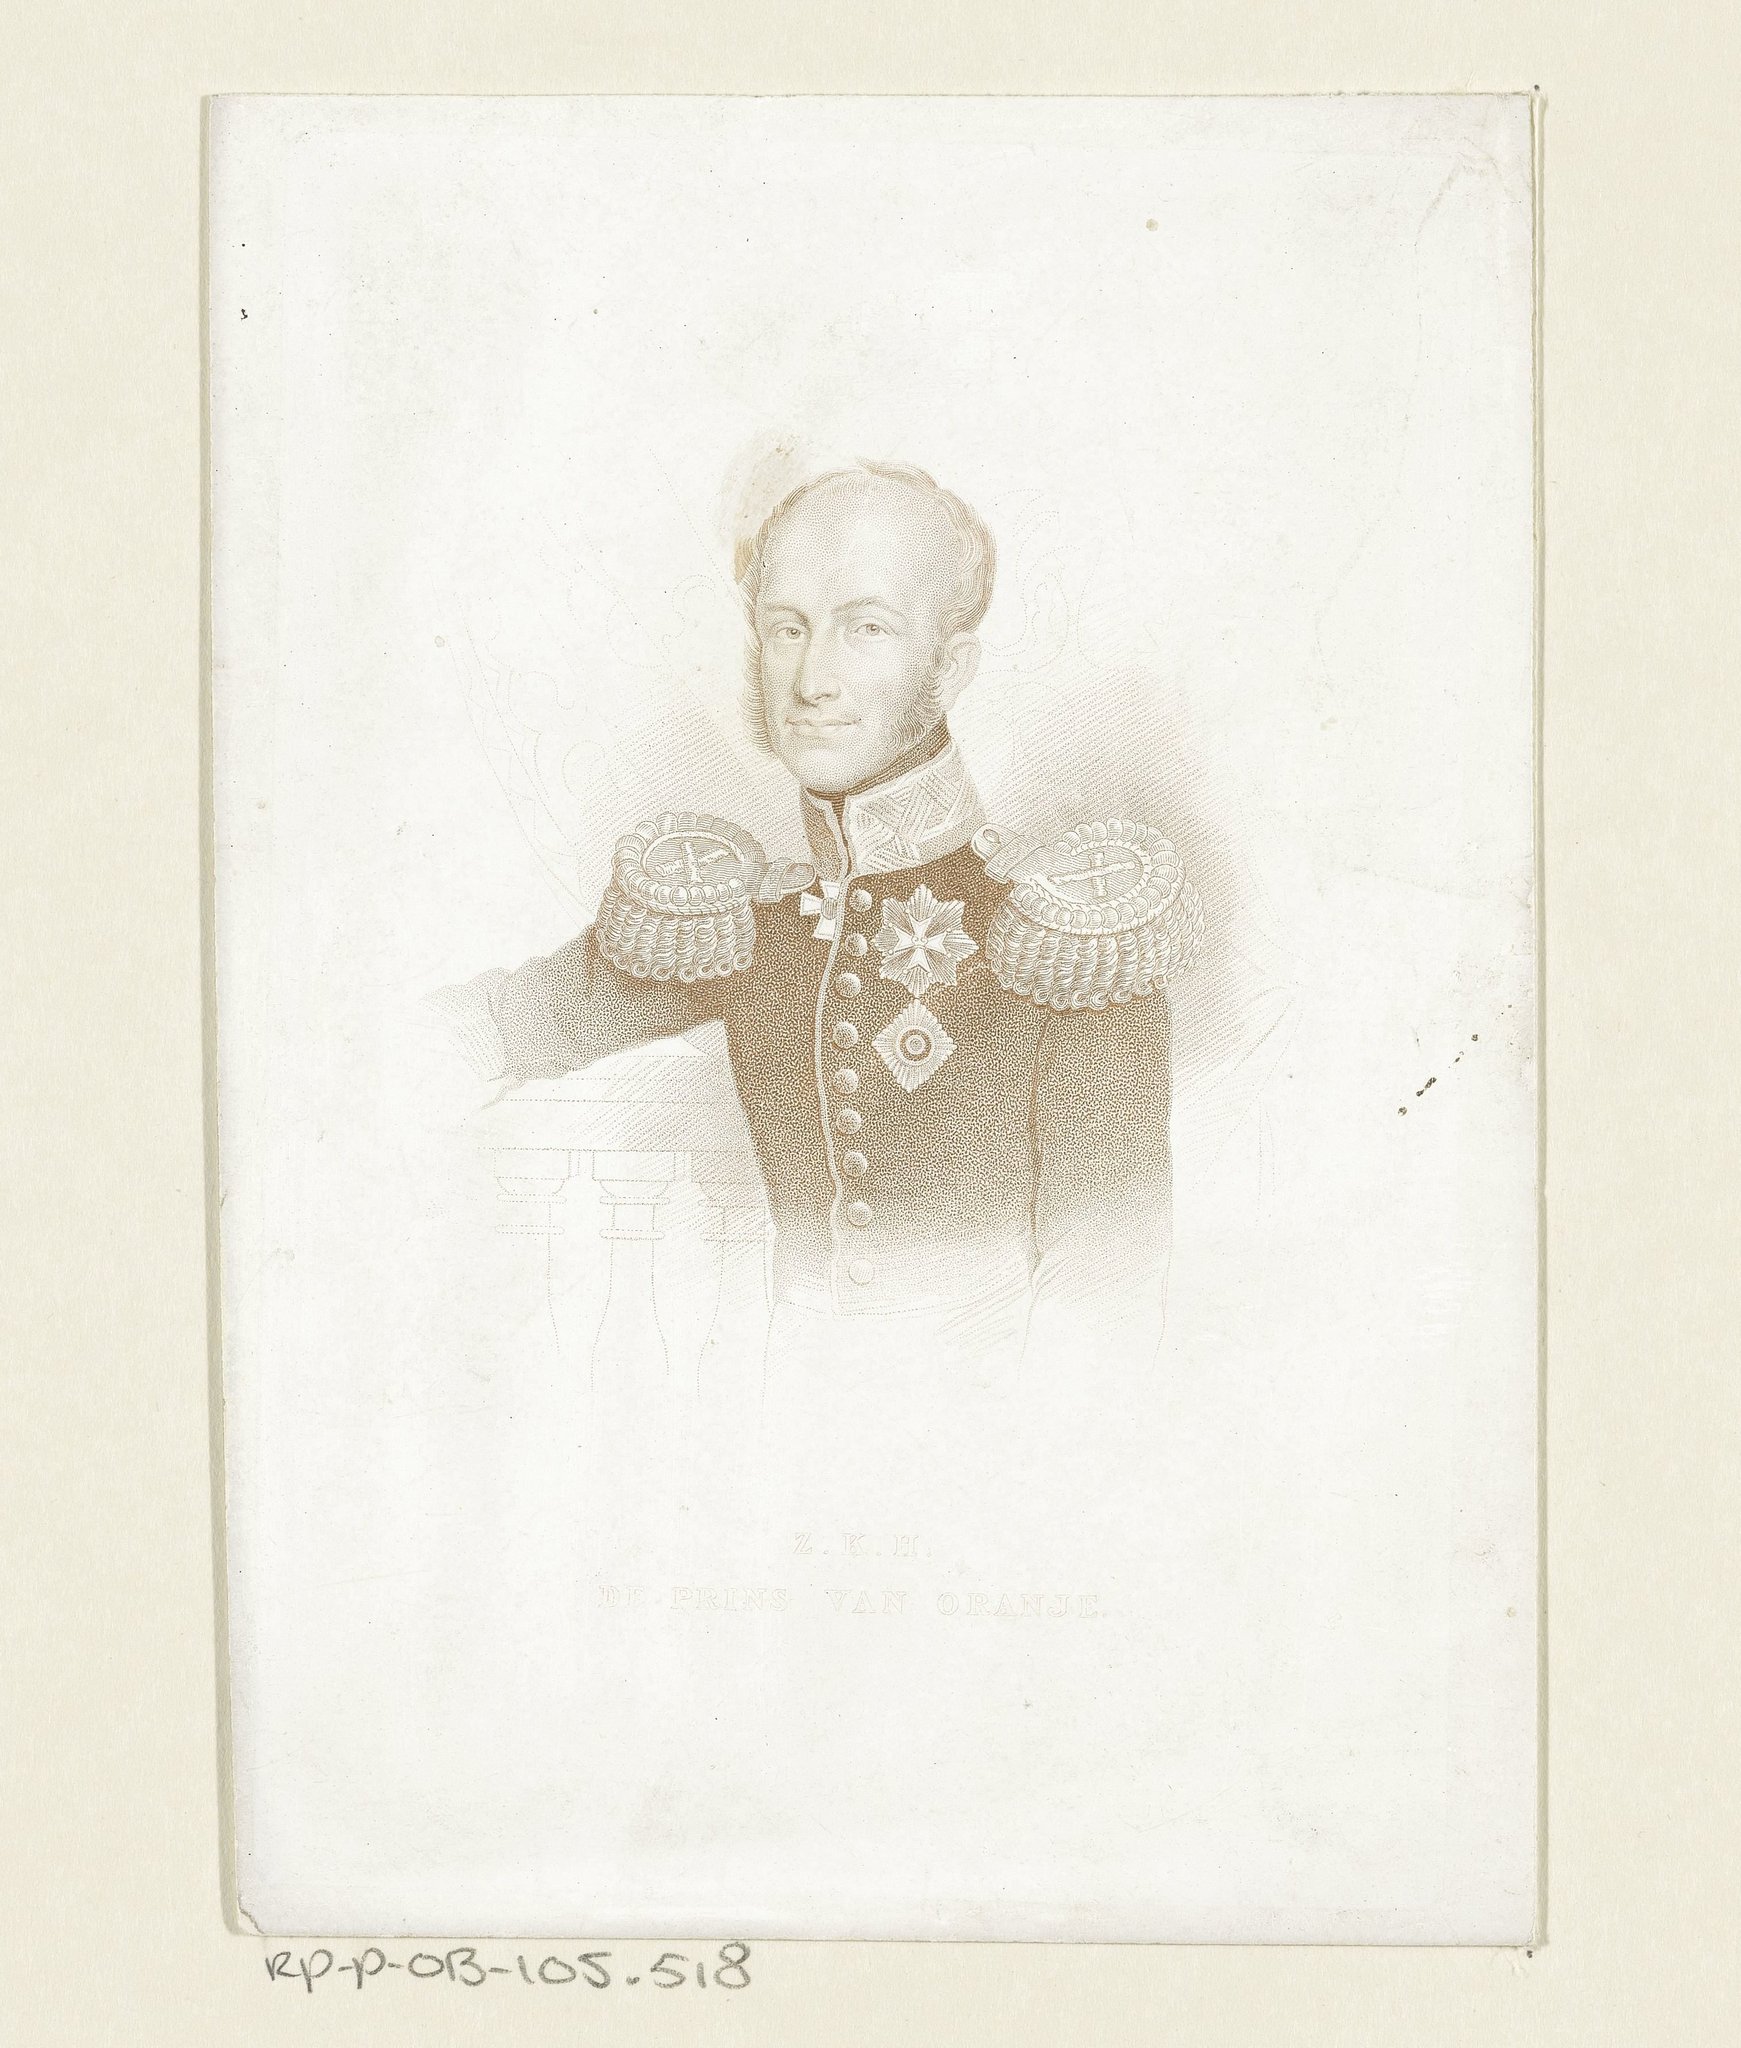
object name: print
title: Portret van Willem II, koning der Nederlanden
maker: Anonymous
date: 1810-1899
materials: paper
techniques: engraving, etching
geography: low countries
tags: the hague, william ii of the netherlands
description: De hier vermelde titel verwijst naar de hoogst verkregen titel van de geportretteerde, niet per se naar de titel die de geportretteerde op deze voorstelling draagt.